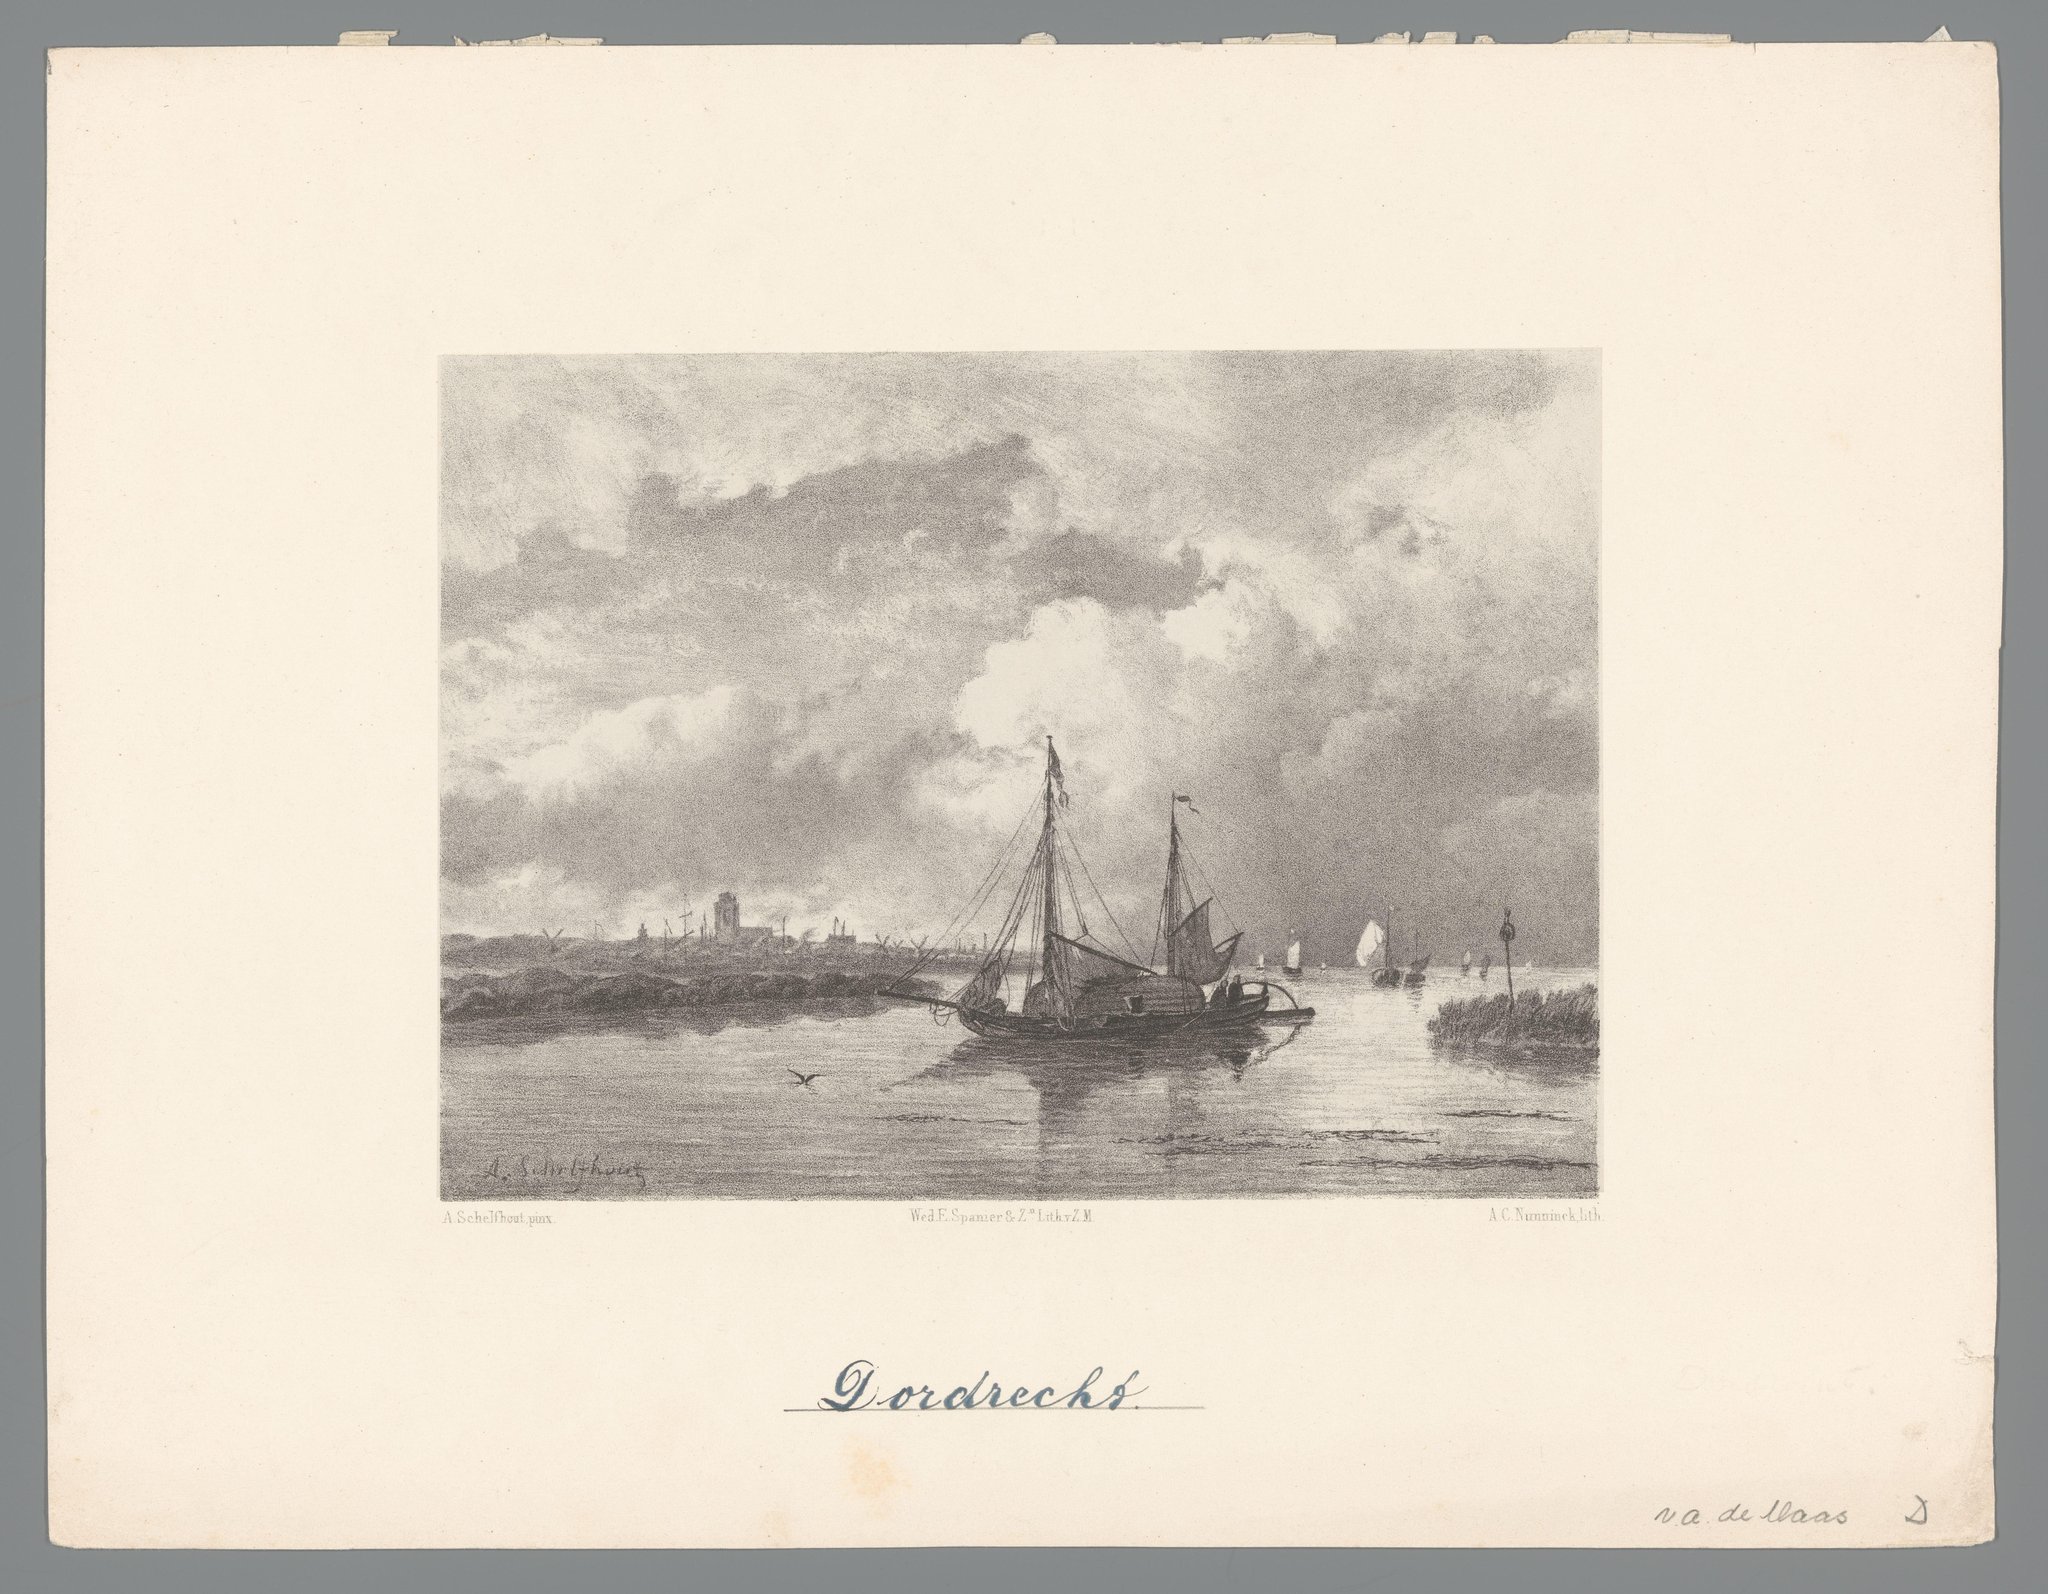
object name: print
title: Zeilboten op de Oude Maas bij Dordrecht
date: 1863-1883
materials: paper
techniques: lithograph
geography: the hague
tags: sailing-ship, sailing-boat, river (+ landscape with figures, staffage), dordrecht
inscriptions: collector's mark: Lugt 2228, inscription: ‘Dordrecht’